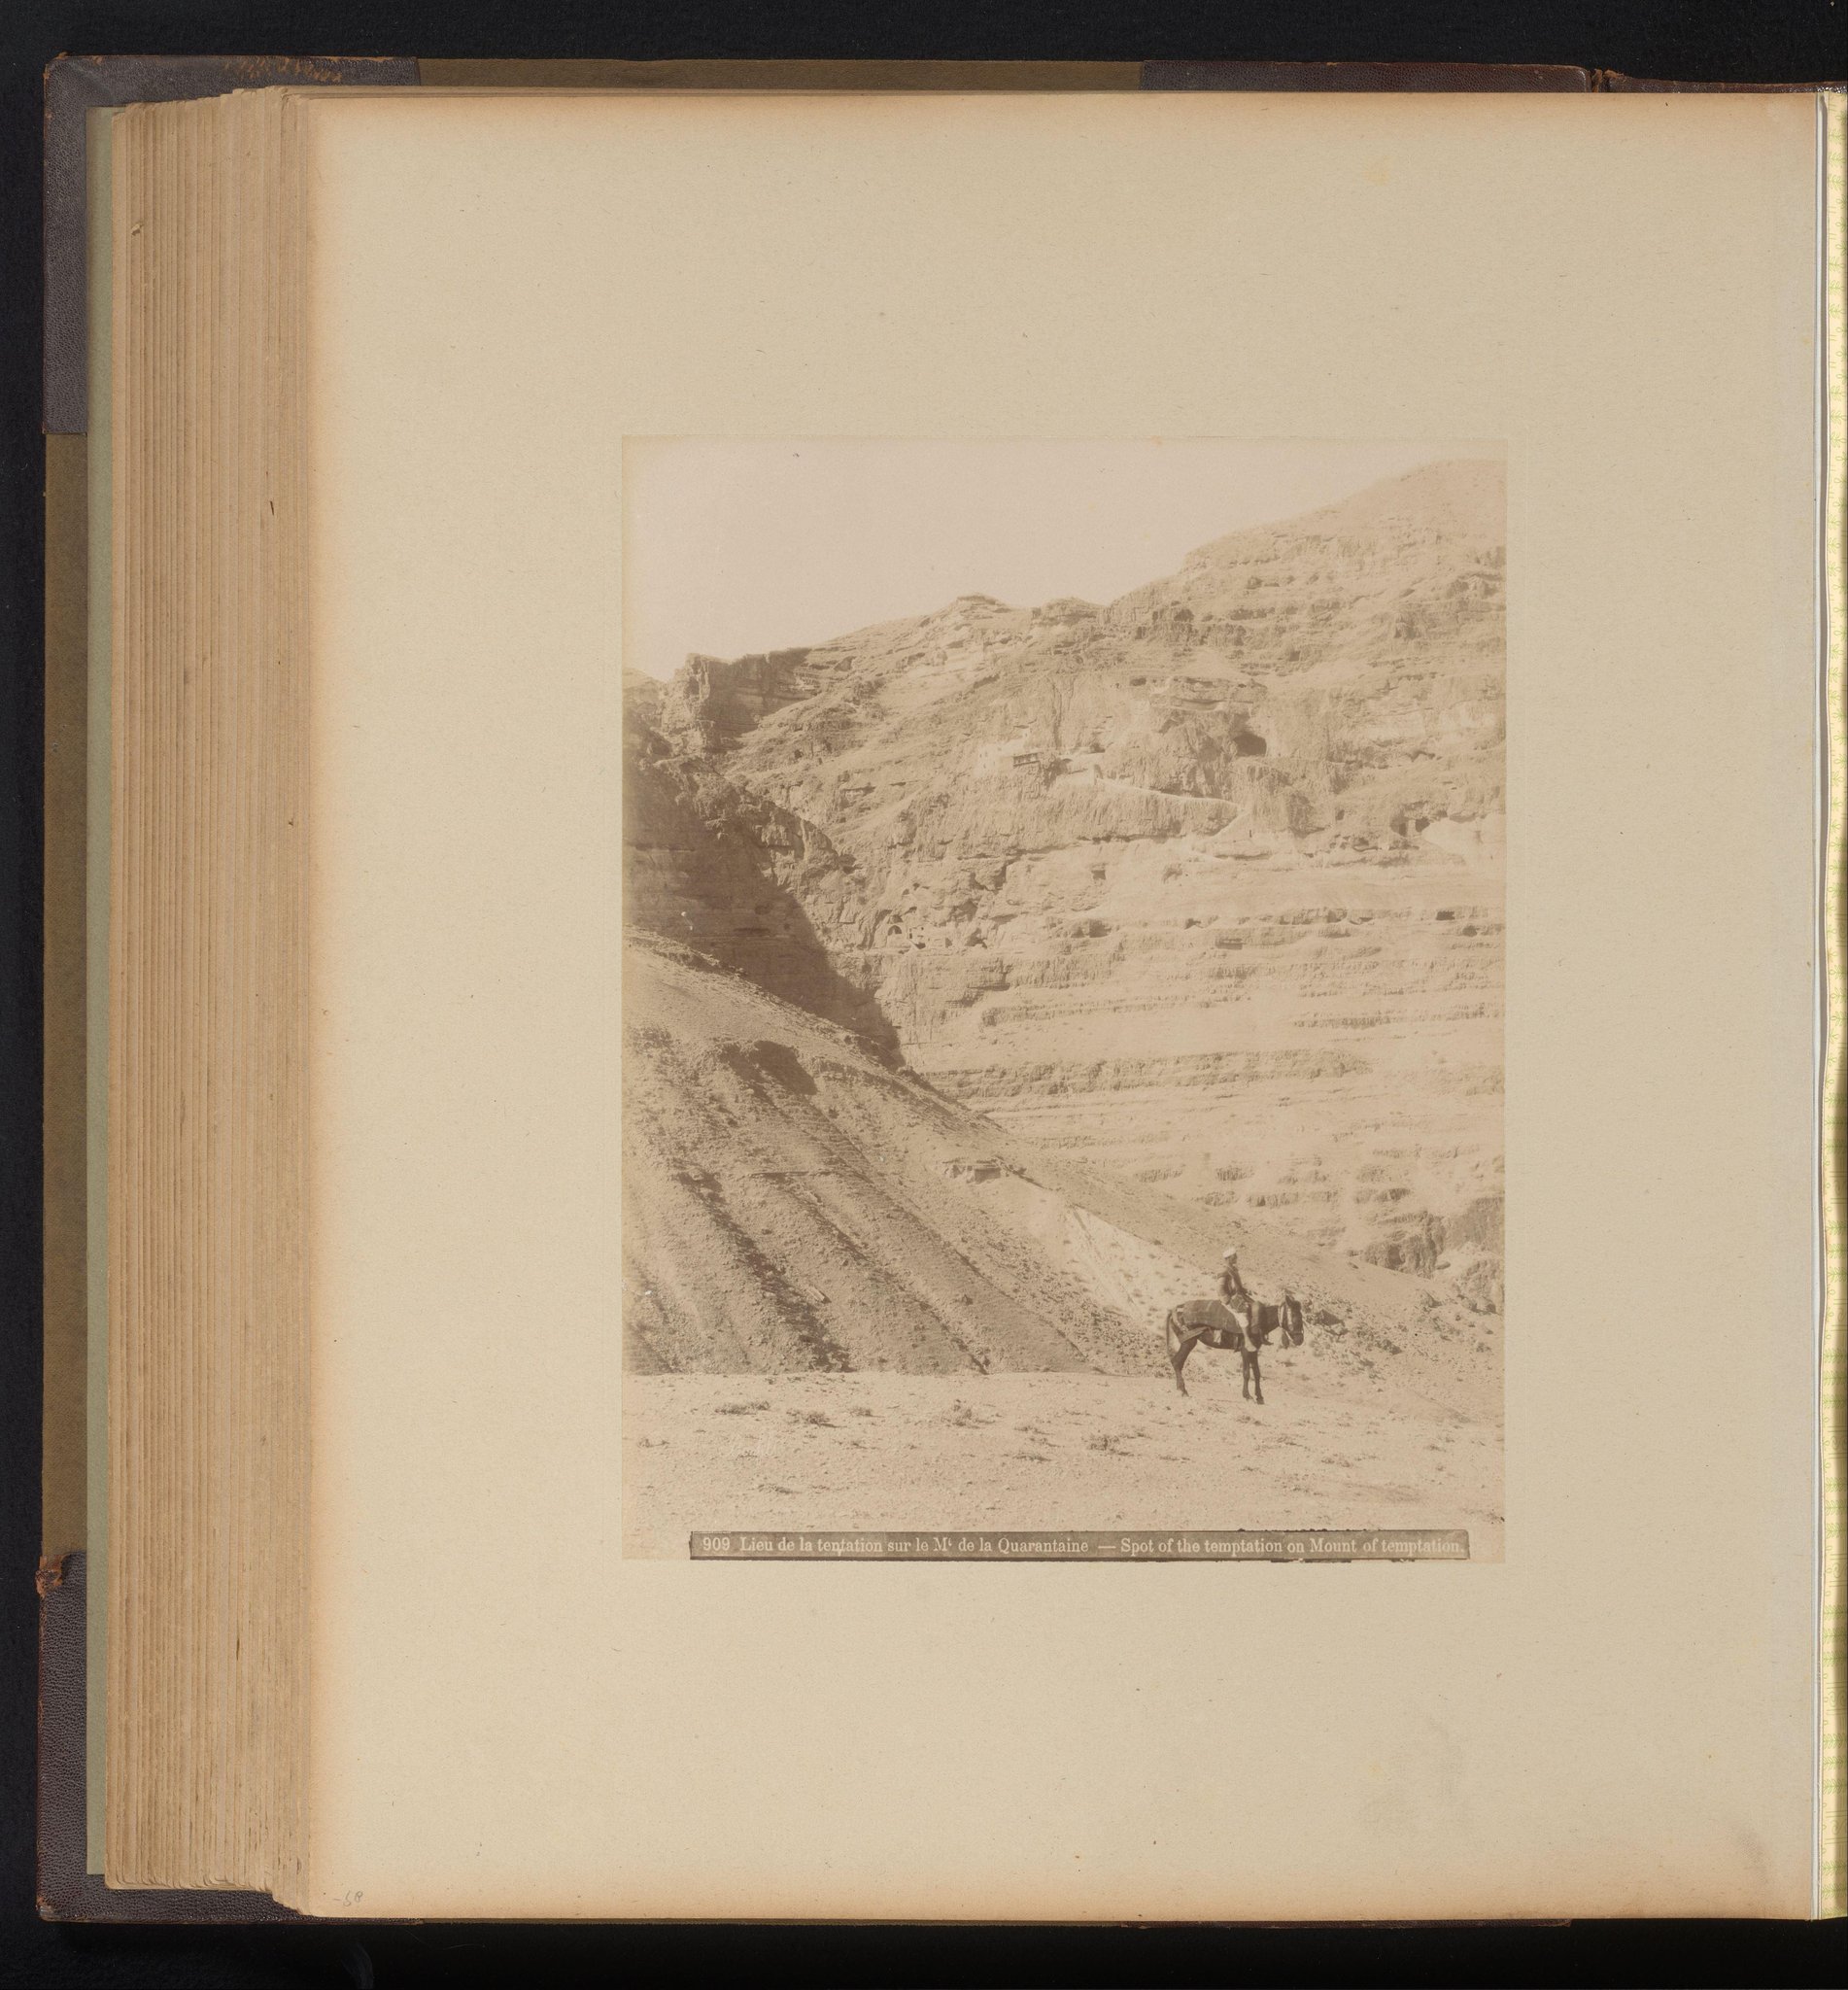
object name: album leaf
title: Berg van de verzoeking van Christus, Jabal al-Quruntul nabij Jericho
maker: félix bonfils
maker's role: fotograaf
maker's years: 1831-1885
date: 1867-1885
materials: paper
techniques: albumen print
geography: jericho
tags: mountains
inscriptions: number: ‘909’